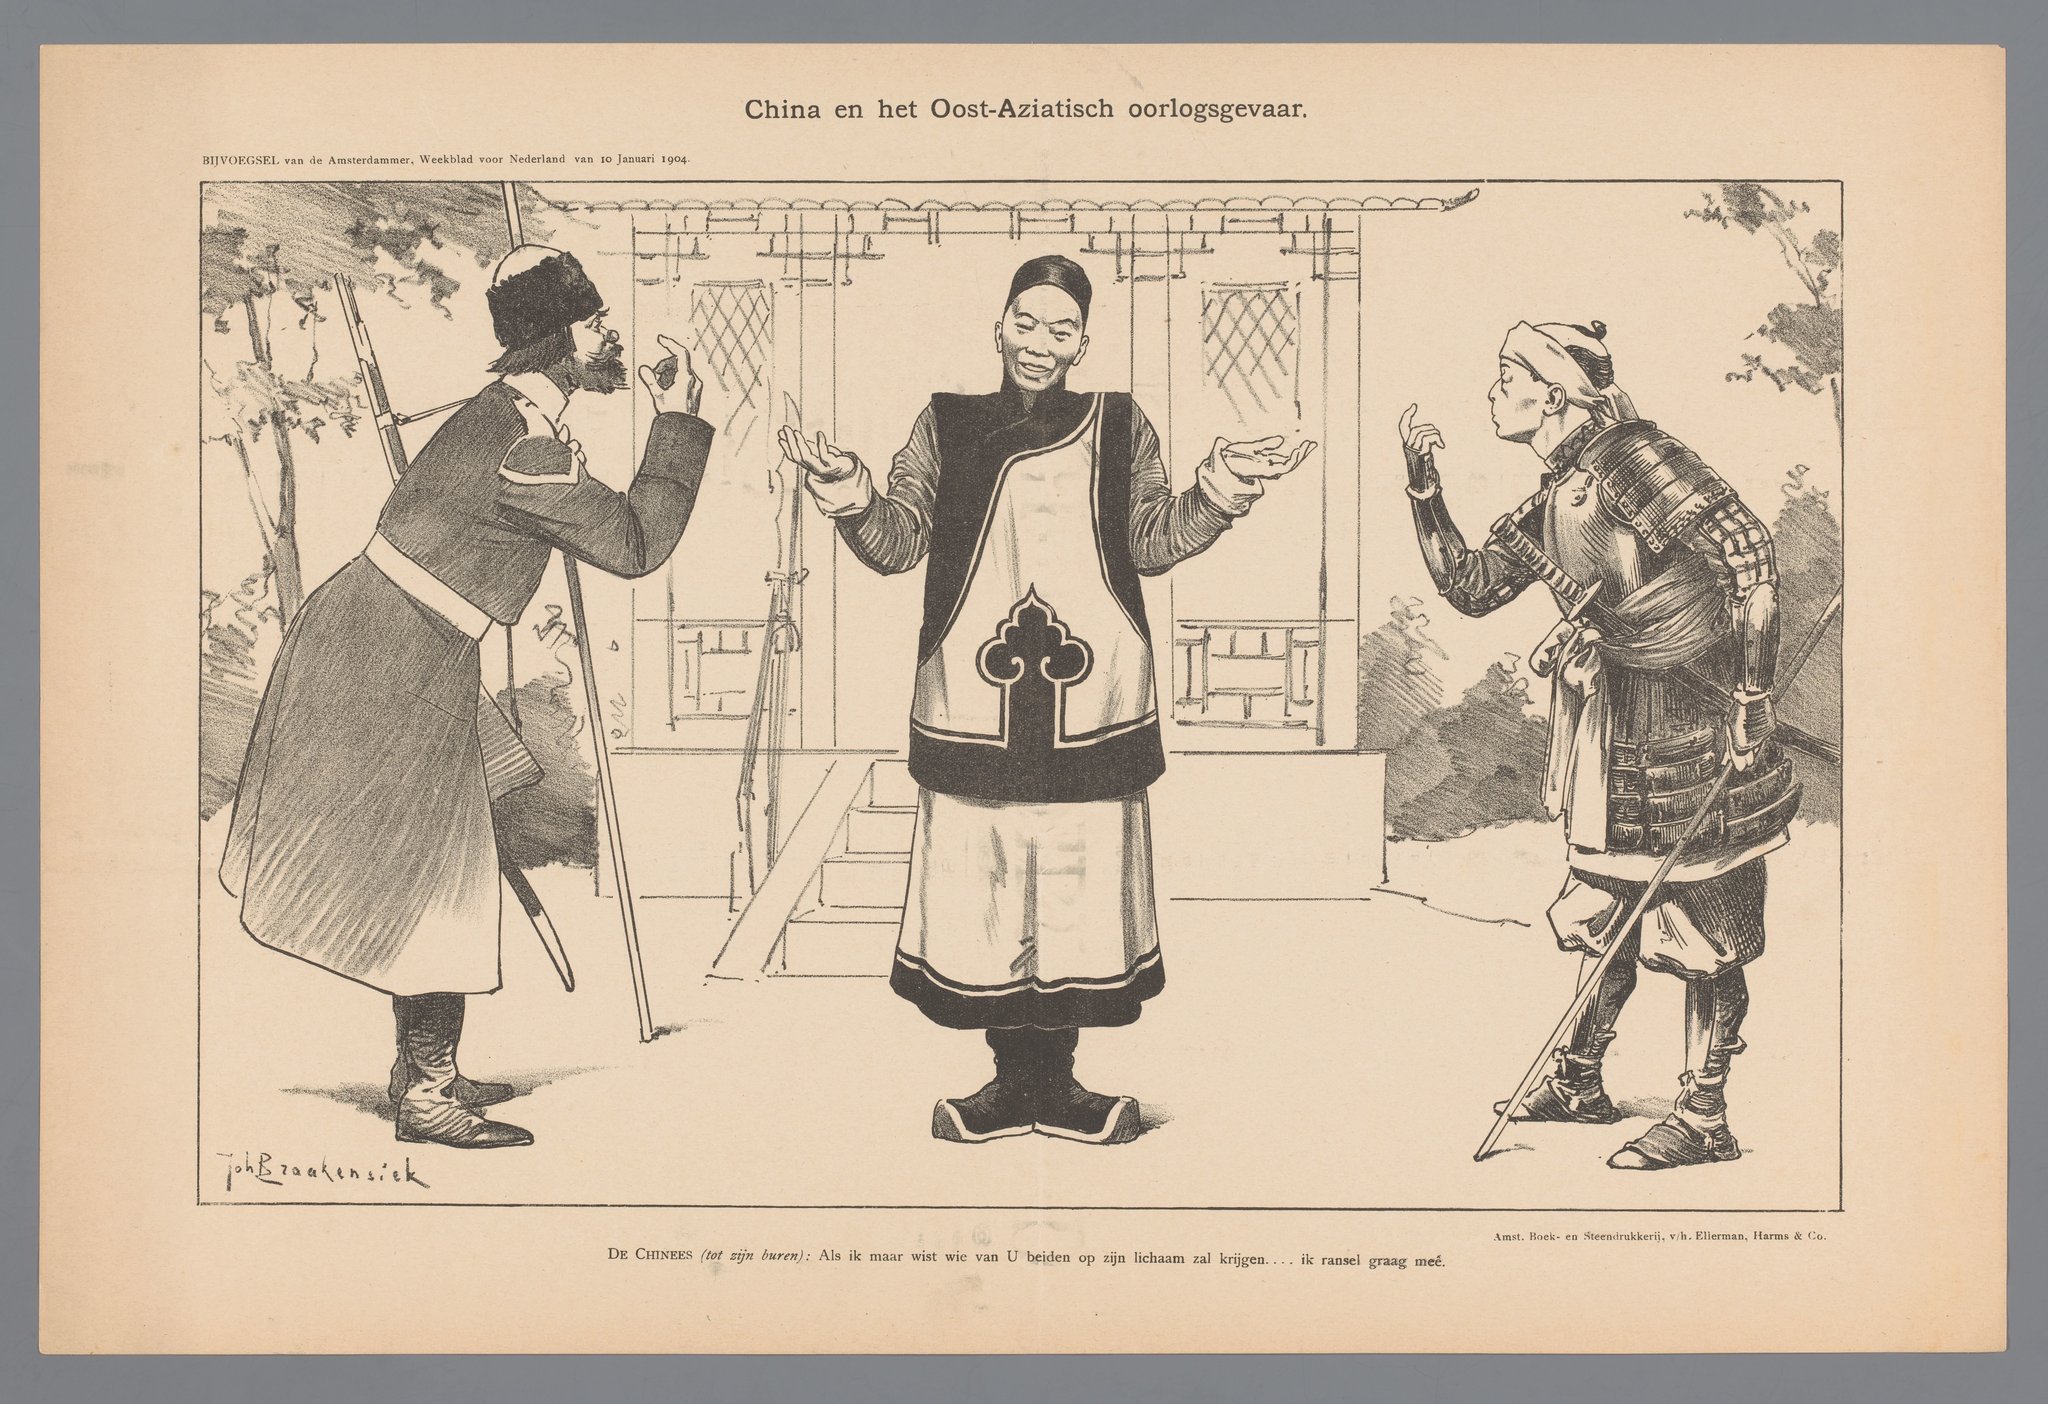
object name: cartoon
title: China en het Oost-Aziatisch oorlogsgevaar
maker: johan braakensiek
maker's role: draughtsman, print maker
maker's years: 1858-1940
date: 1904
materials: paper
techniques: lithograph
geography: amsterdam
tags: personifications of countries, nations, states, districts, etc. (+ nation; national), political caricatures and satires, russia, china, japan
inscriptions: date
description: Prent uit het bijvoegsel van: De Amsterdammer. Weekblad voor Nederland, 10 januari 1904.